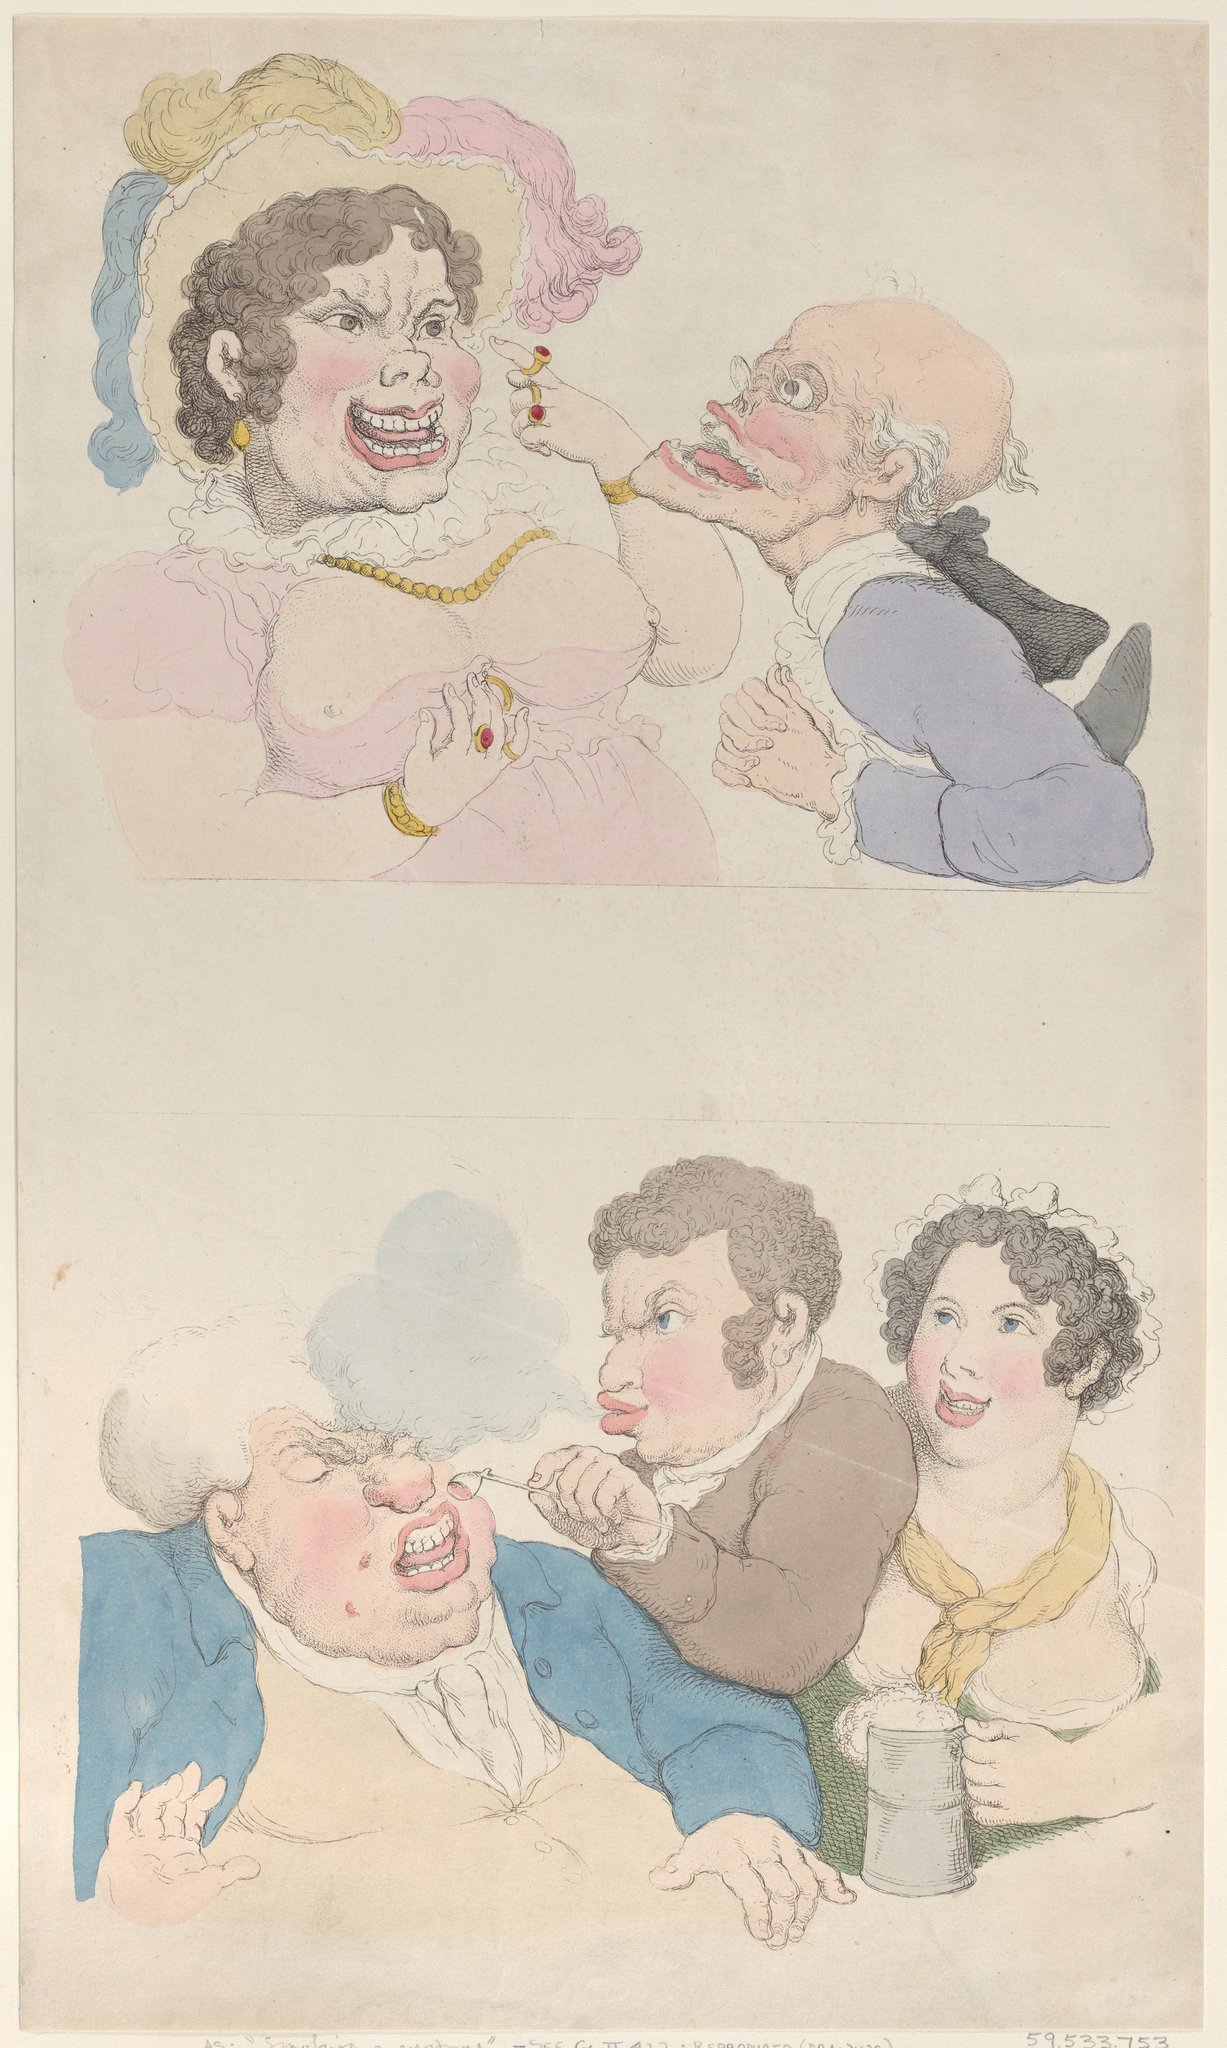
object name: print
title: A Man Enticed by a Woman; and Smoking a Customer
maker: thomas rowlandson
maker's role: artist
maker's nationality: british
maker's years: 1757-1827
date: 1800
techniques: etching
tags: satire,men,women